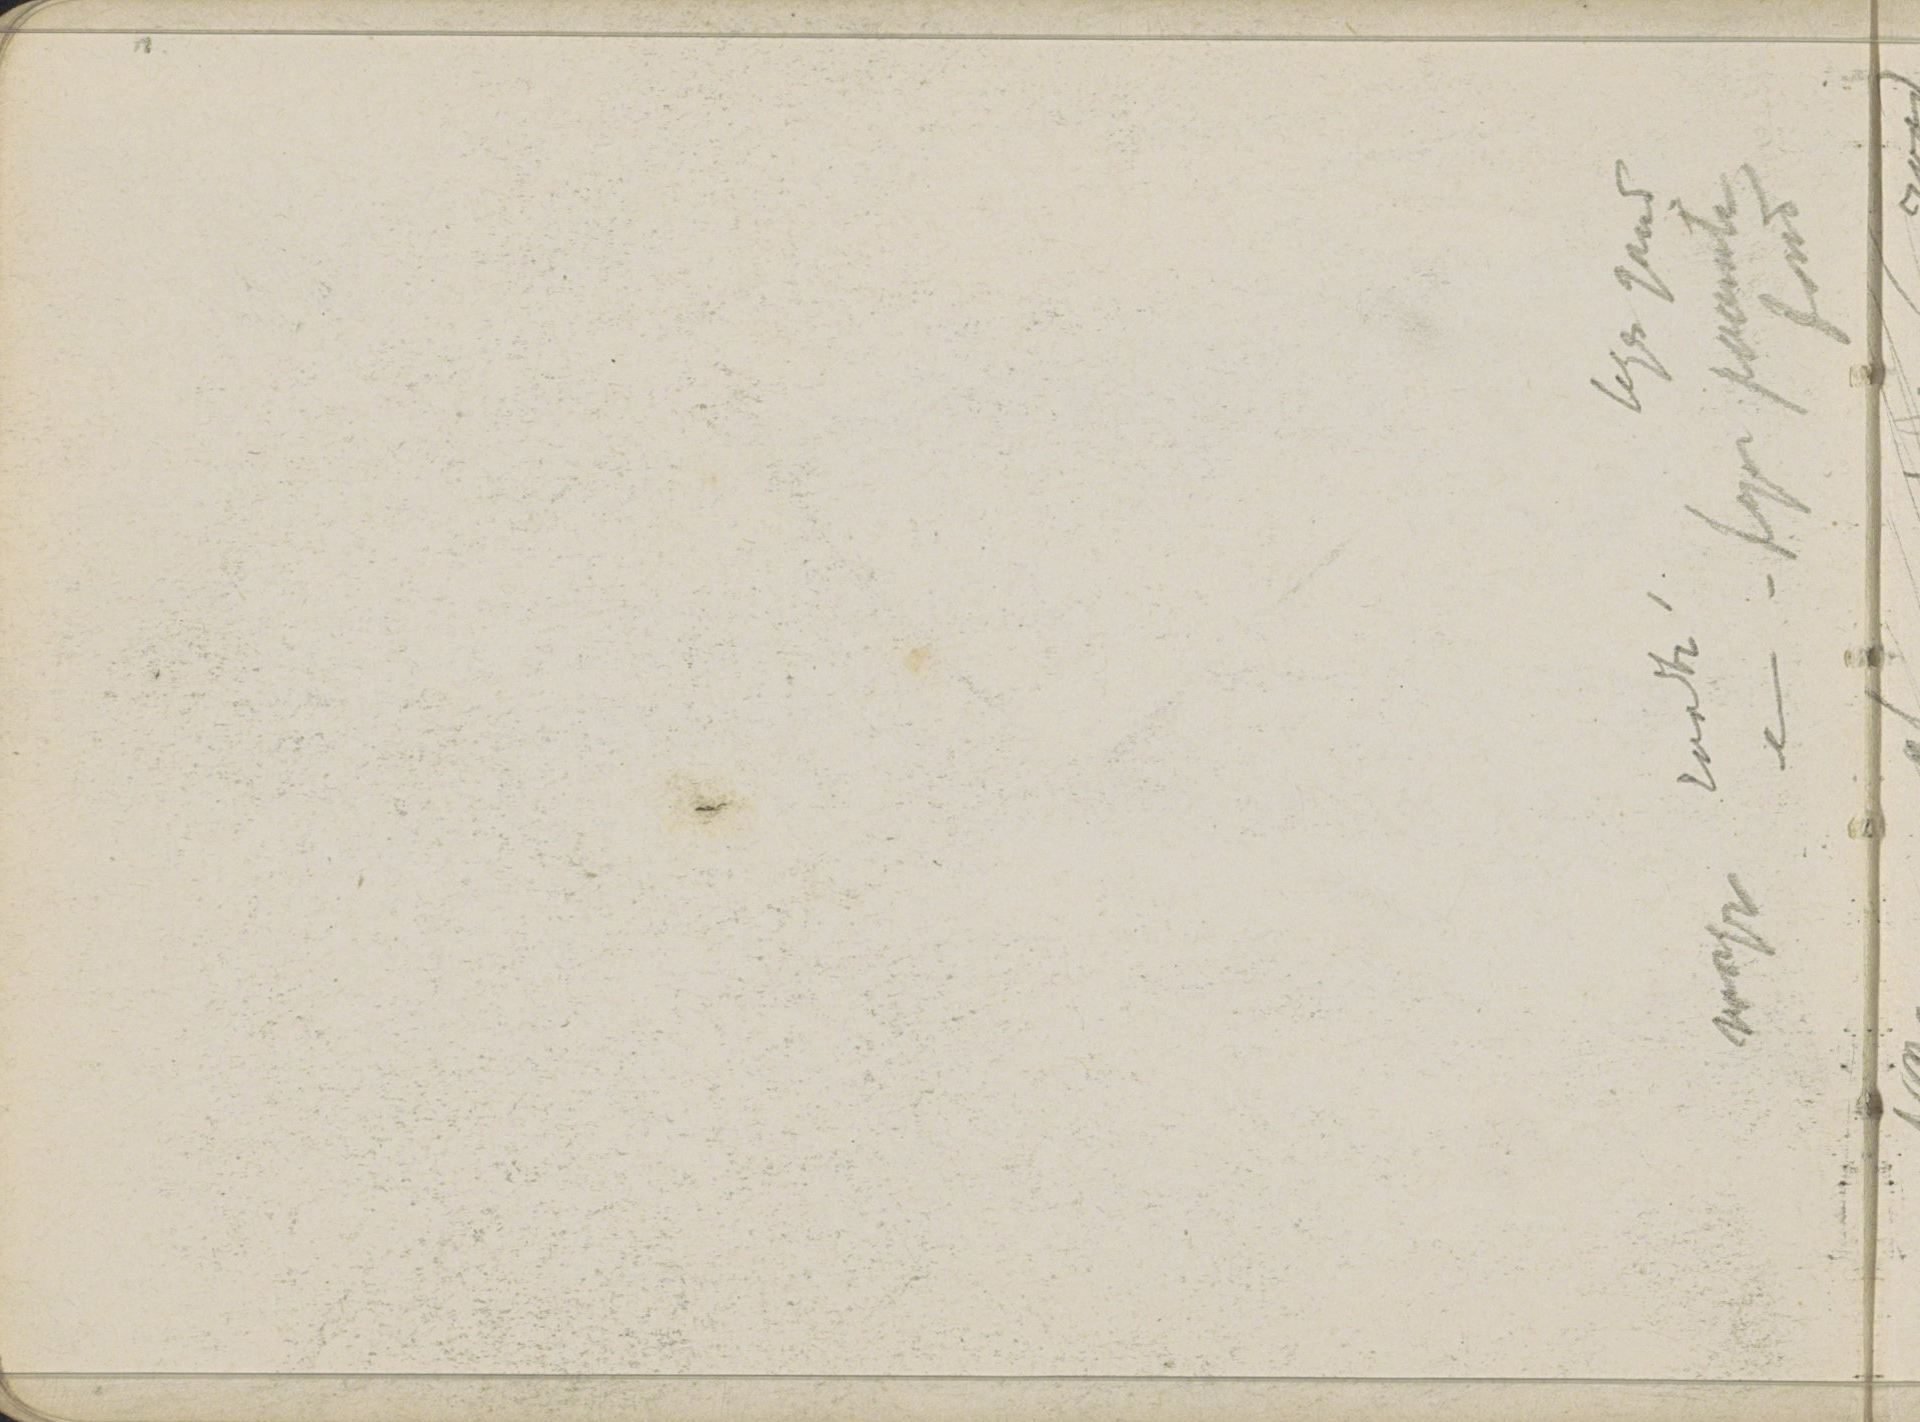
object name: sketchbook leaf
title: Blad met annotaties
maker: johan antonie de jonge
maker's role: draughtsman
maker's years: 1864-1927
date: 1884-1927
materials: paper, pencil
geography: south holland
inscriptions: kleurnotitie, handgeschreven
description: Blad met annotaties. Blad 14 verso uit een schetsboek met 33 bladen.